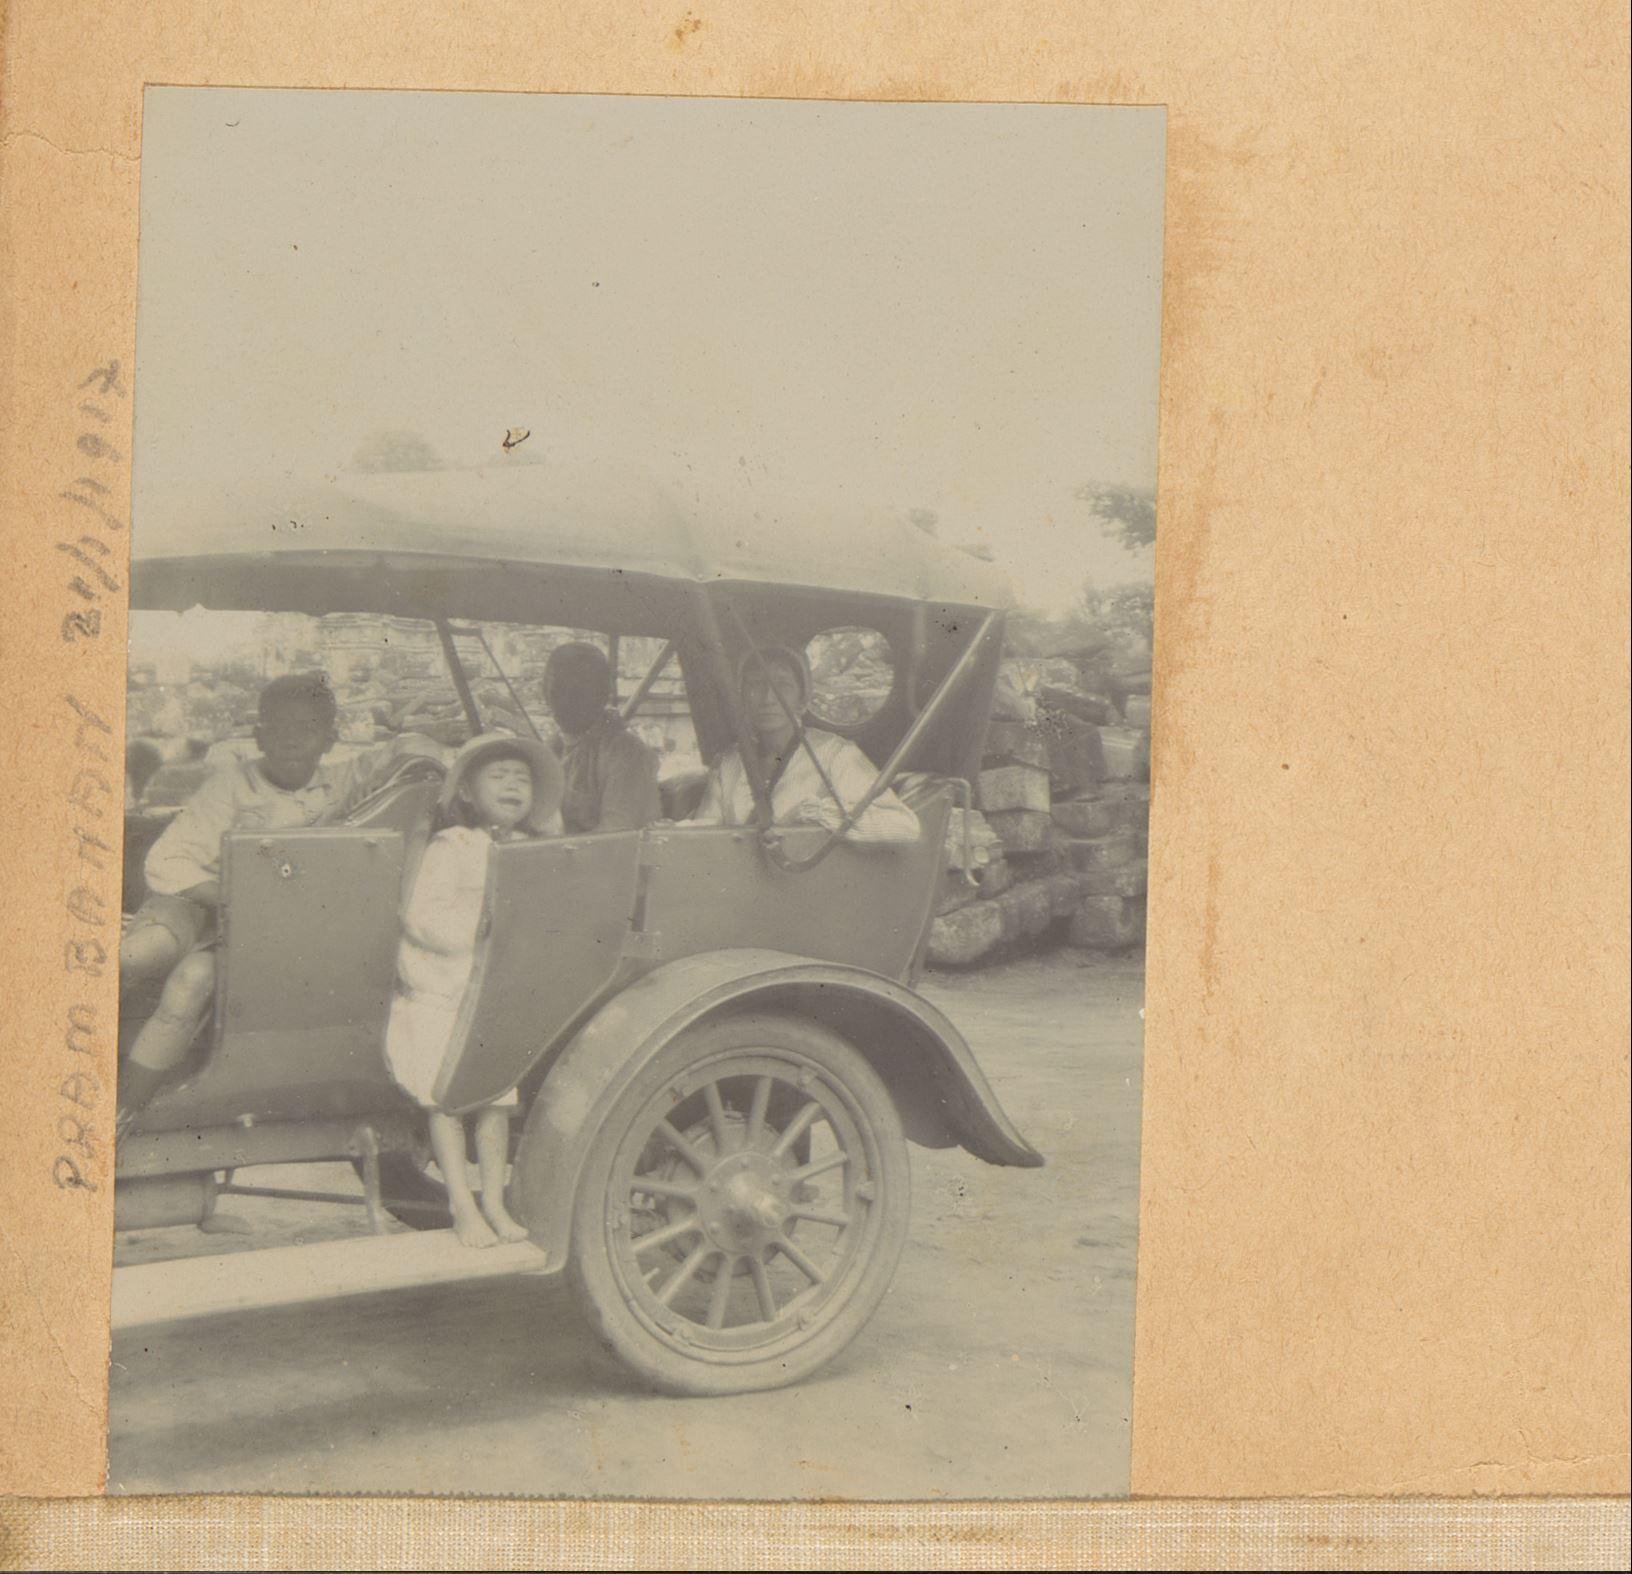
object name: photograph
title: Mensen met huilend kind in een auto in Prambanan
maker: Anonymous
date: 1917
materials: photographic support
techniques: daylight paper print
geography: prambanan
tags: parents with their children, automobile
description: Onderdeel van Familiealbum met foto's van een familie in de voormalige kolonie Nederlands-Indië en van een suikerfabriek in Purworejo.